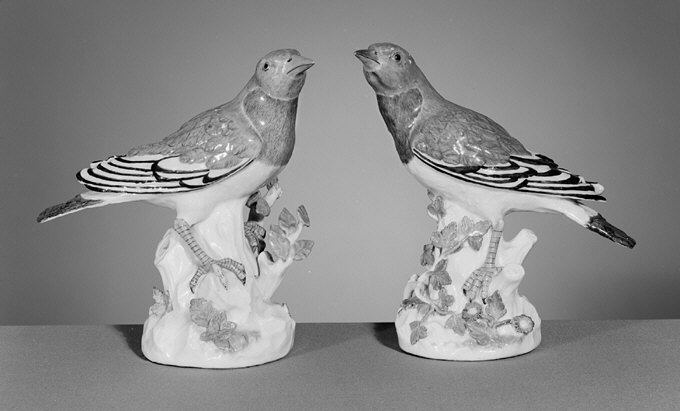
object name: figure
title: Thrush (one of a pair)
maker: meissen manufactory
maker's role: manufactory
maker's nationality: german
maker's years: 1710-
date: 1740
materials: hard paste porcelain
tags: birds,leaves